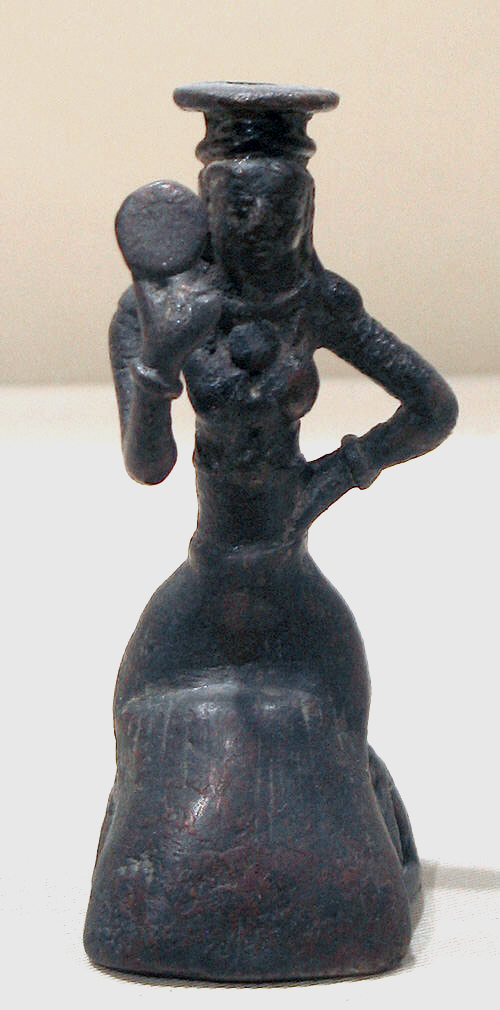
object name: mirror handle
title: Mirror Handle with a Woman Holding a Mirror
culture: gandhara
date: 100 BCE-100 CE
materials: bronze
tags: gandhara,women